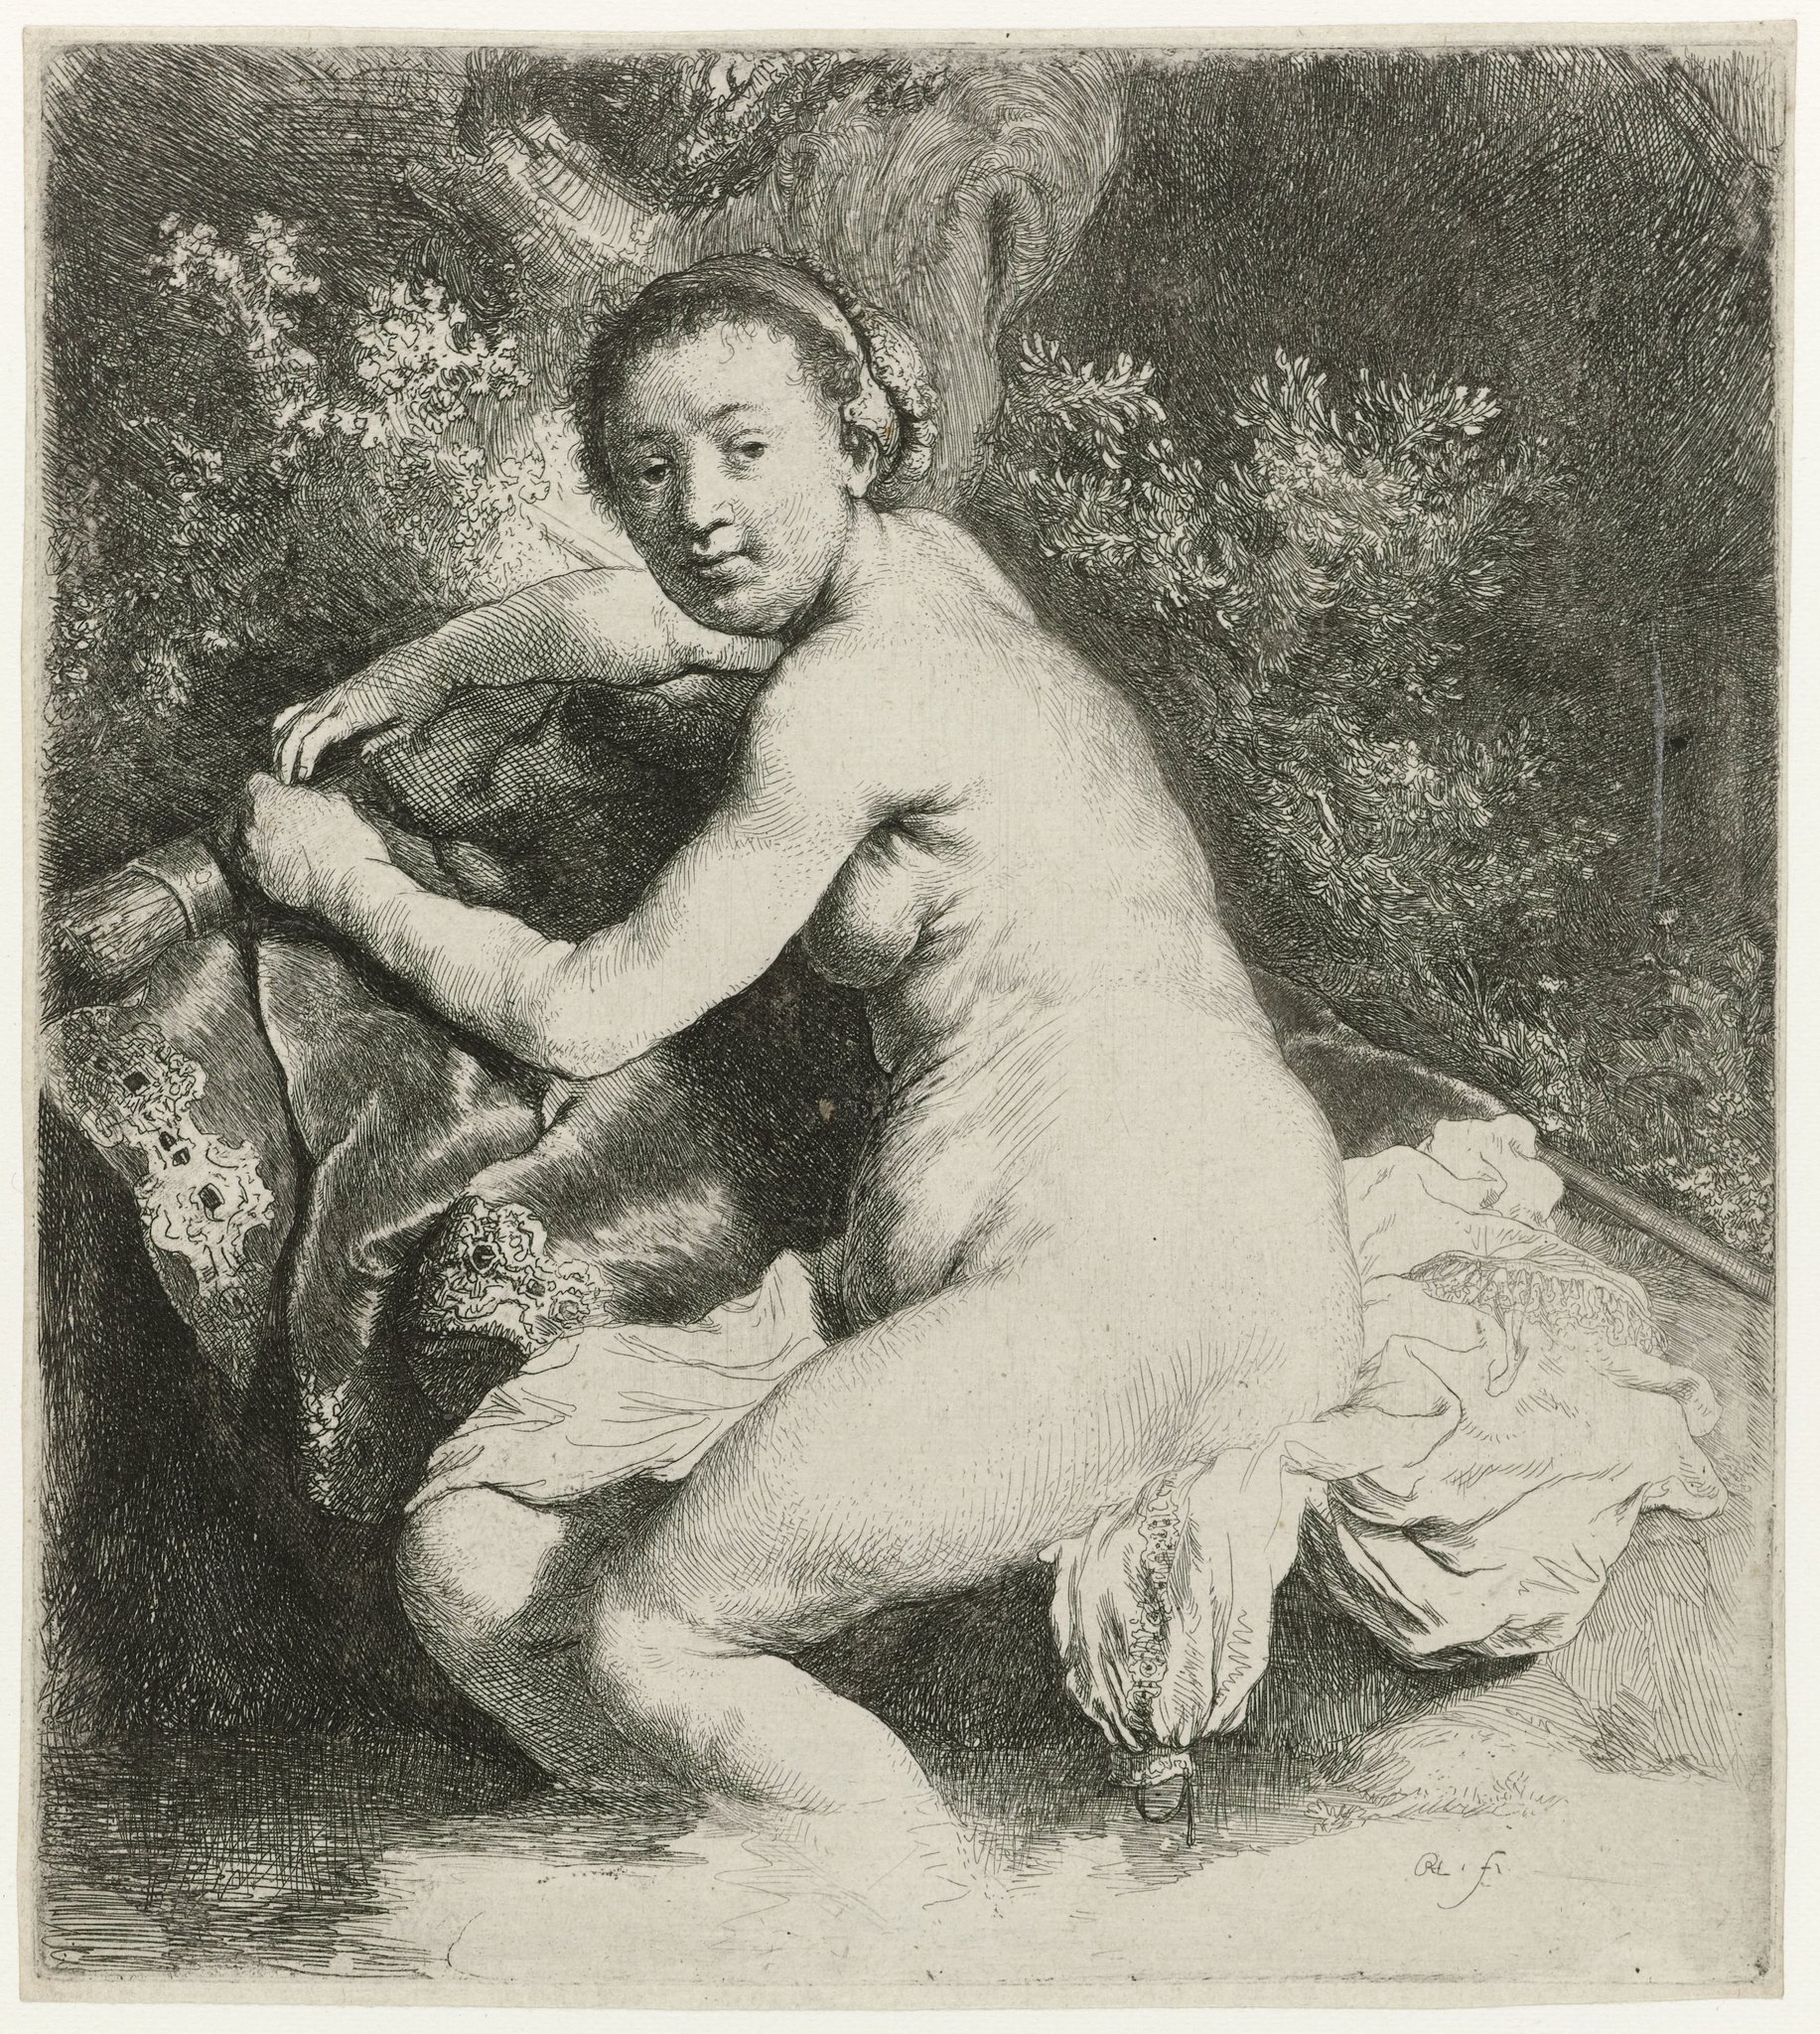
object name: print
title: Diana at the bath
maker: rembrandt van rijn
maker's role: draughtsman, painter, print maker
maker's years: 1606-1669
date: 1631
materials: paper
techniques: etching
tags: diana bathing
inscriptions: monogram: ‘RHL.f.’, collector's mark: Lugt 240